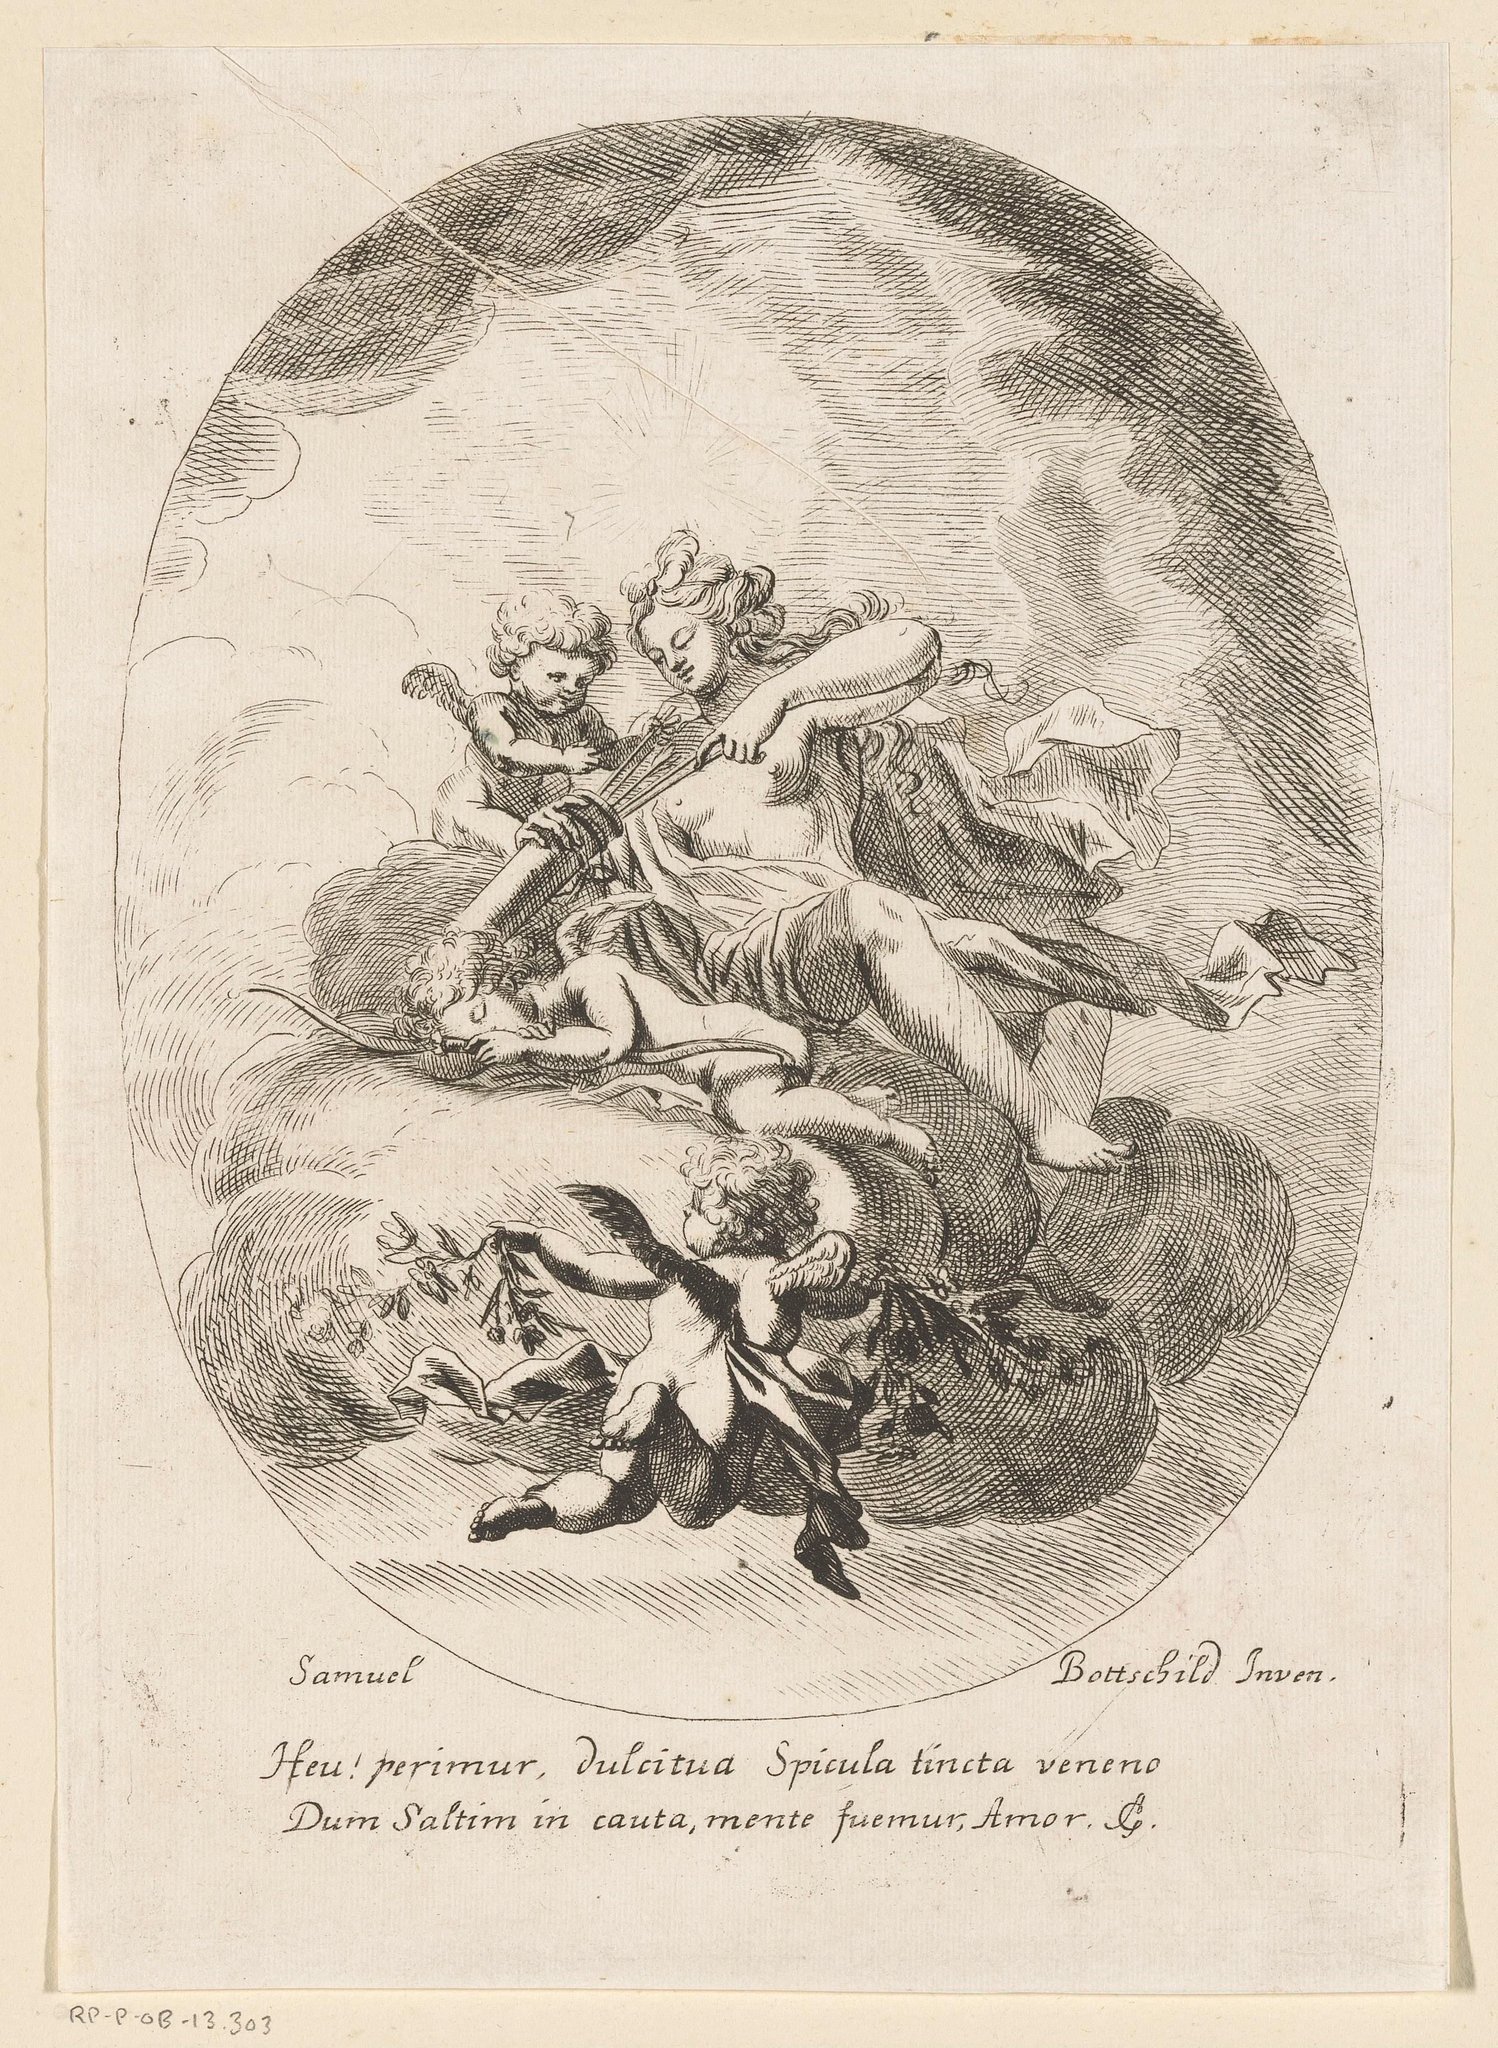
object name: print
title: Diverse ontwerpen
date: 1693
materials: paper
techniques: etching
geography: dresden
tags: sitting or standing on clouds - aa - female human figure, (story of) venus (aphrodite), cupids: 'amores', 'amoretti', 'putti'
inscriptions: collector's mark: Lugt 240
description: Prent afkomstig uit de serie 'Opera Varia Historica, Poetica & Iconologica', uitgegeven in 1693. Deze serie omvat vrijwel het complete oeuvre van de kunstenaar en bestaat uit 48 prenten, voornamelijk ontwerpen voor plafonds.